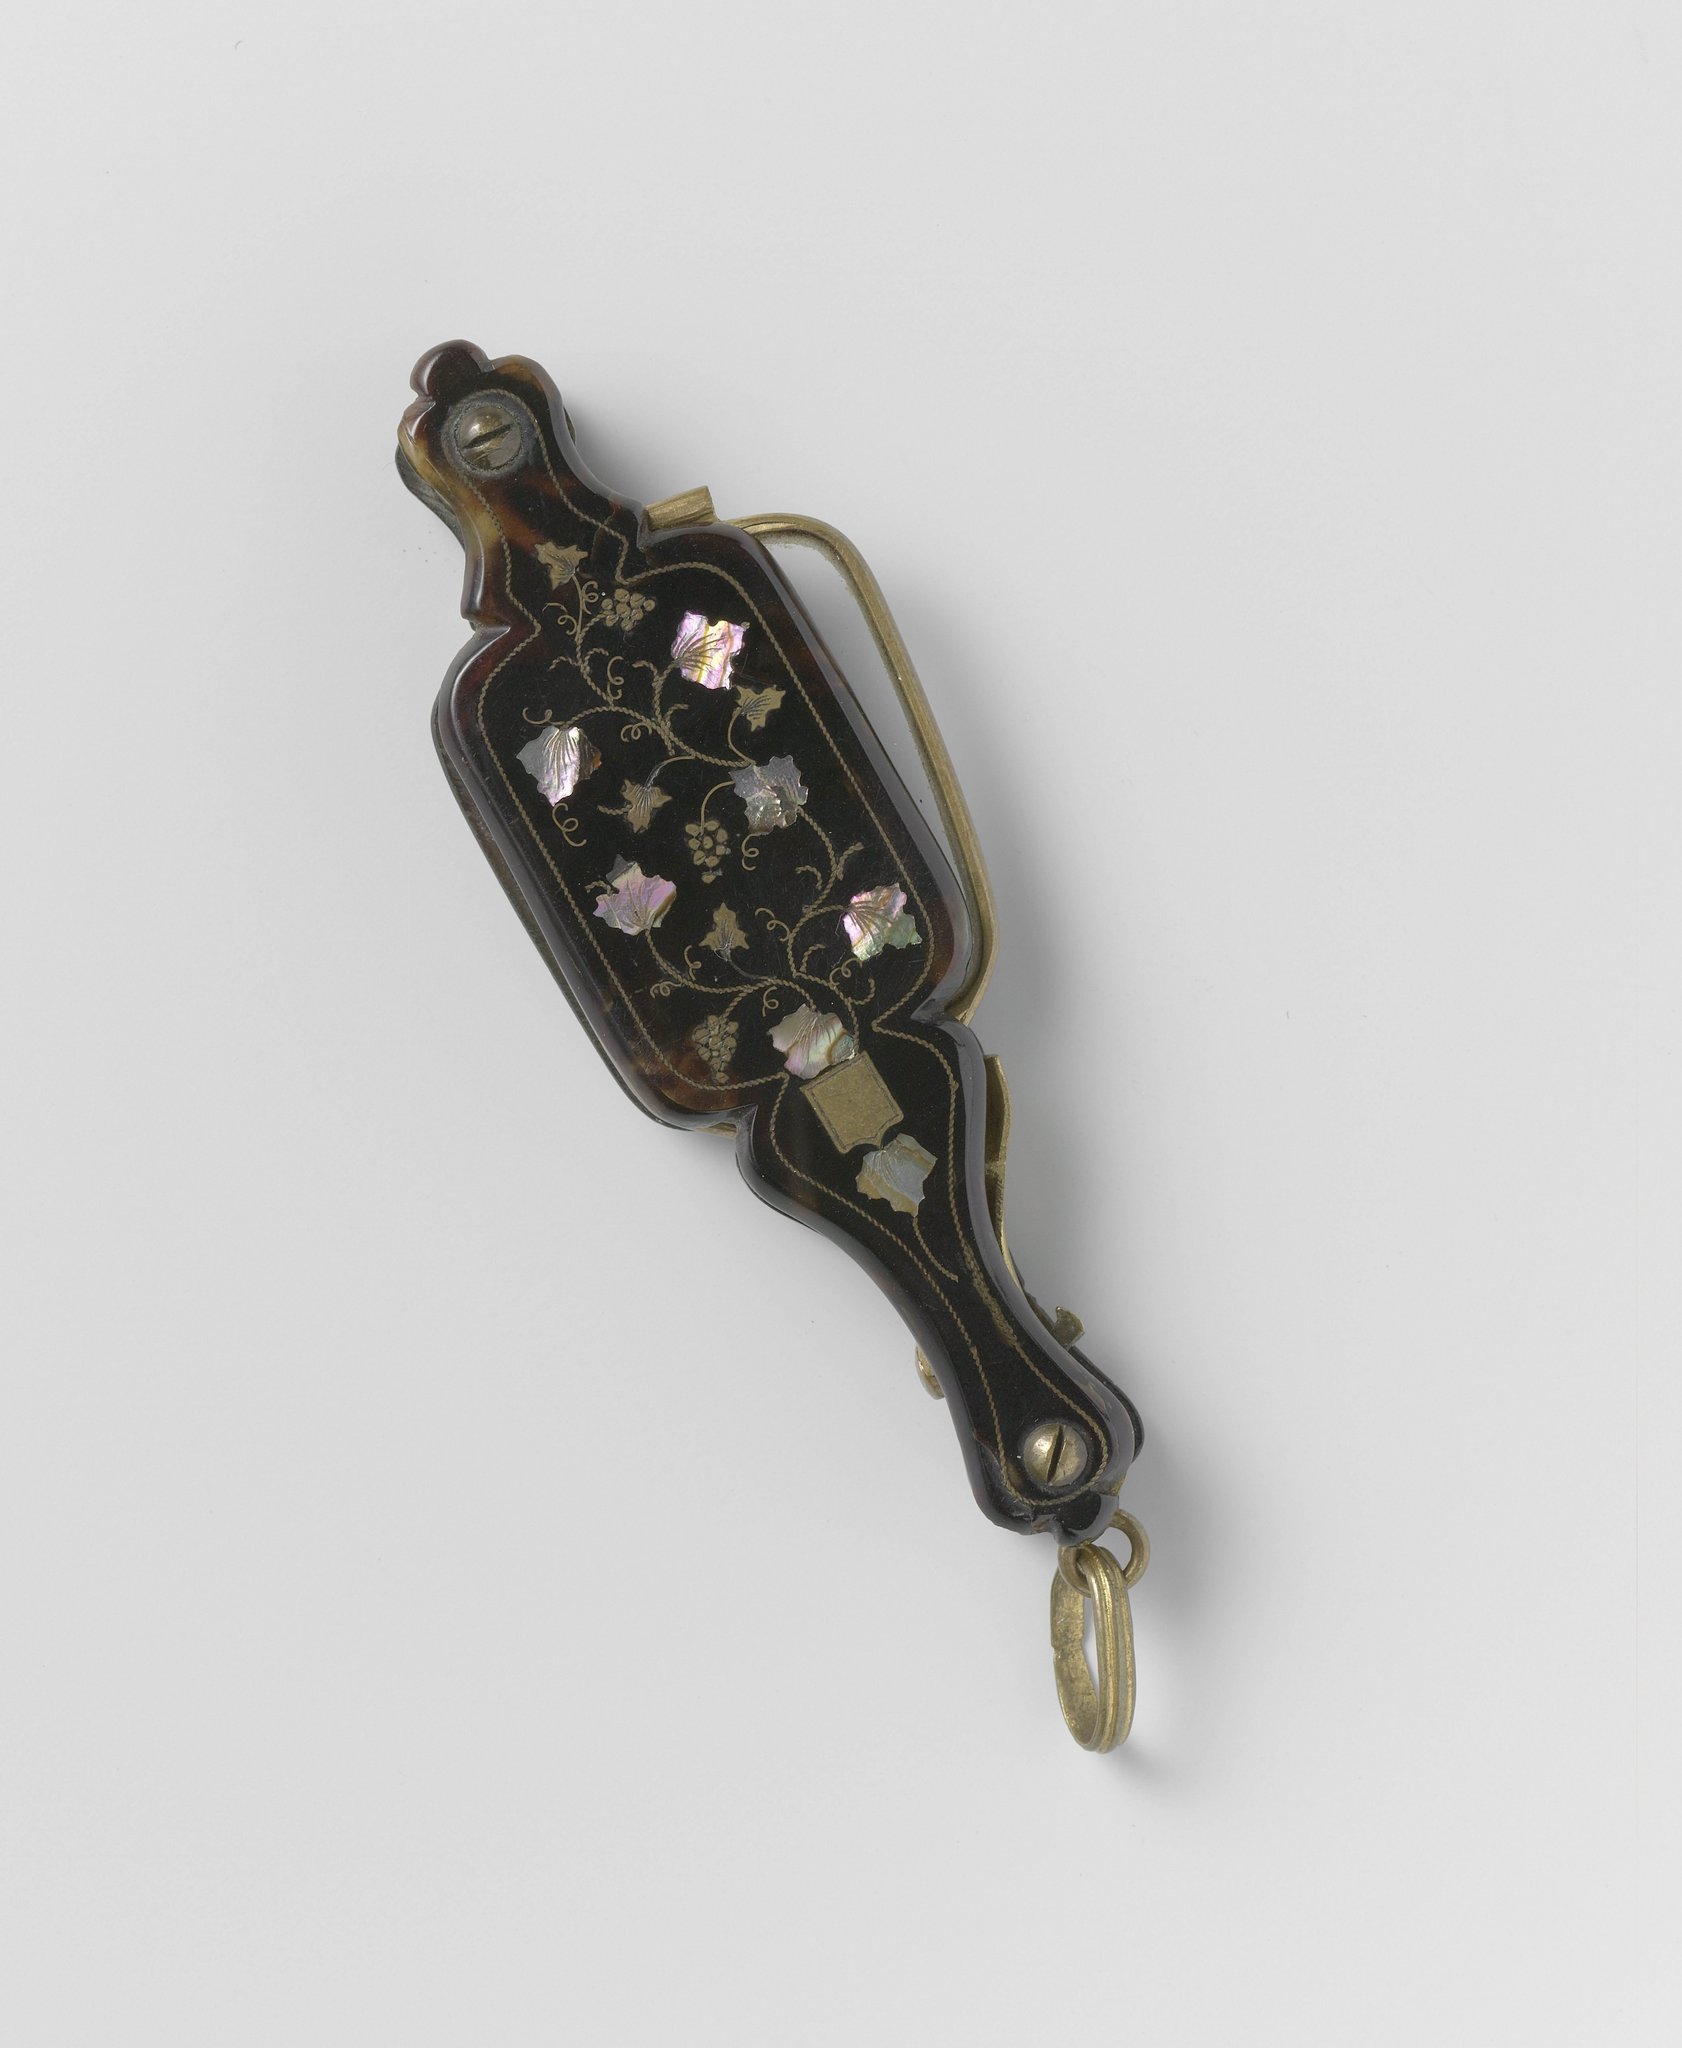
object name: spectacle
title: Scharnierlorgnet met montuur van koper in steel van schildpad ingelegd met parelmoer en koper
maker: Anonymous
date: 1845-1865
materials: copper, glass, mother of pearl, shell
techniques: forging, grinding, inlay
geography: netherlands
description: Bril, face à main van koper en ingelgde zwarte steen. De vouwbril heeft een rechthoekige glaasjes, in koper gevat, scharnierend in de dubbele neusboog en één der hoeken, zodat hij verdwijnt in een rechthoekig, opzij open doosje van steen, waaraan twee verlengde uiteinden zitten: 1. voor het oogje voor een lint en als handvat, 2. voor het scharnier, een knipveertje is het mechaniek van het openen. De zarte steen is ingelegd met parelmoer en koper, in de vorm van bloemen, ranken en takken. ook een koperen wapenschild, dat leeggebleven is, is ingelegd.